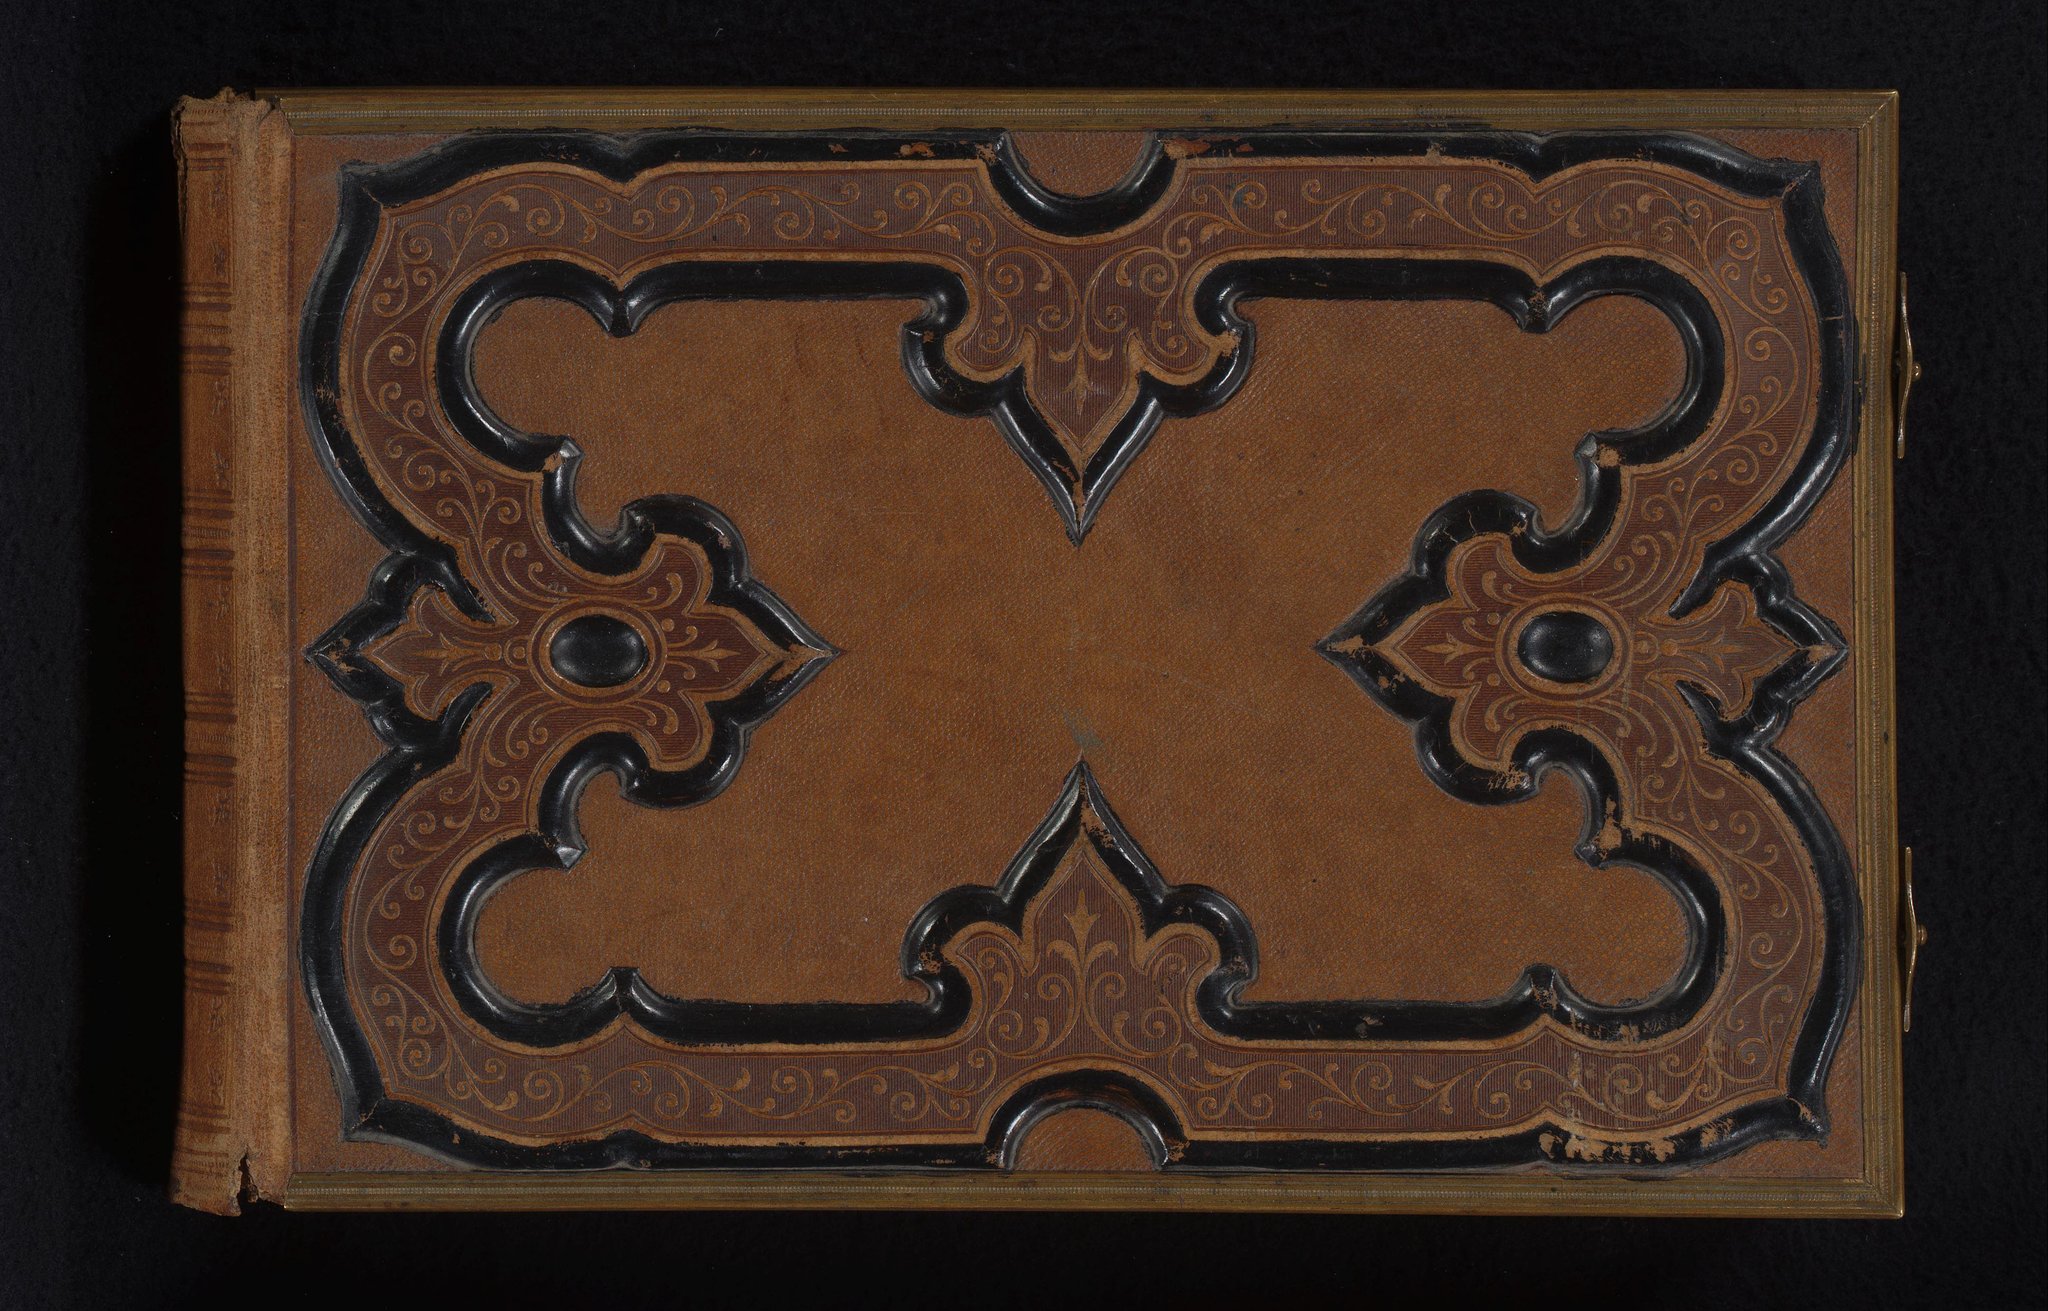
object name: slip in album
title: Fotoalbum (leeg)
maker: Anonymous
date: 1860-1900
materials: cardboard, copper, leather, paper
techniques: color on snow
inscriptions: collector's mark: ‘DIENST/ VERSPREIDE/ RIJKSKOLLEKTIES/ (...) A 890’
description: Fotoalbum met 48 pagina's met op iedere pagina naast elkaar twee met gepreegde rand omkaderde passe-partouts voor cartes-de-visite.